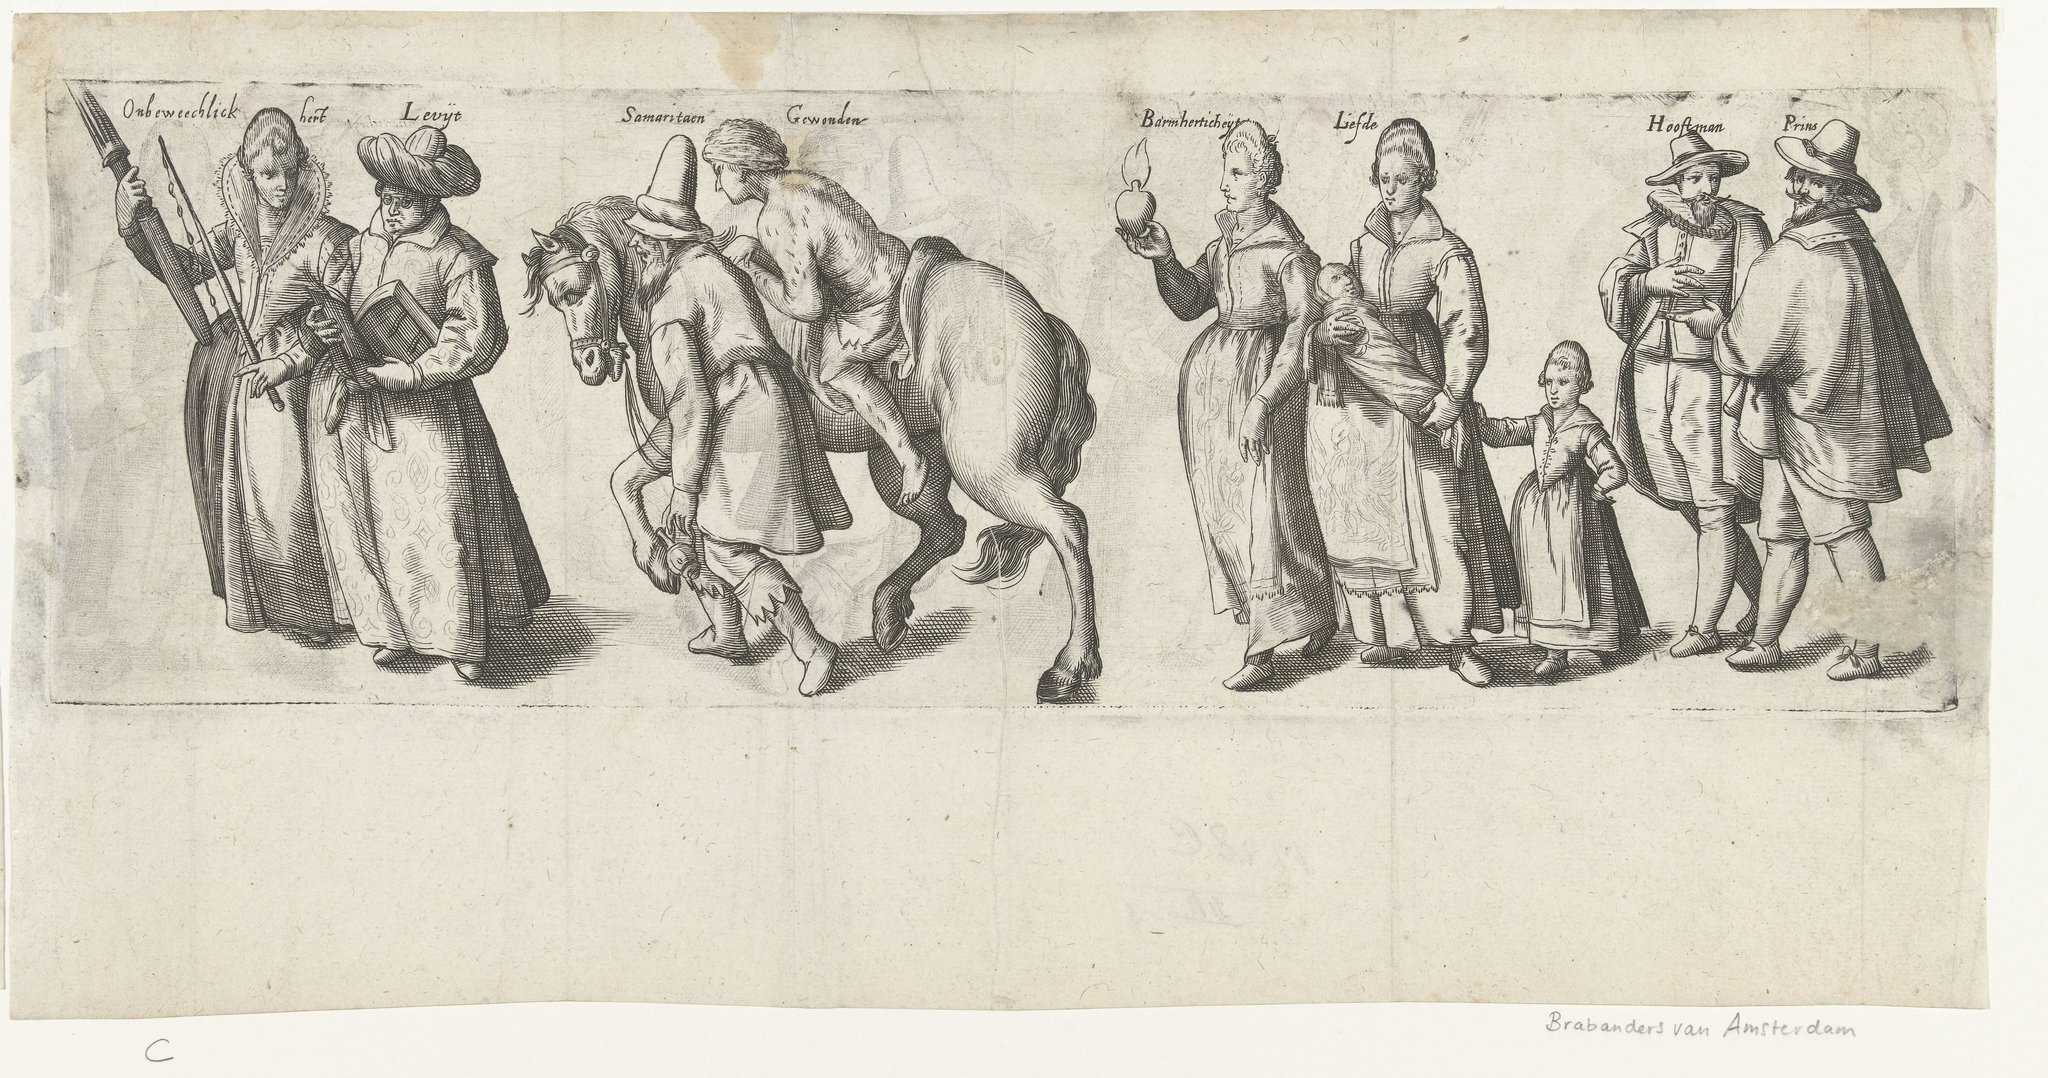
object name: print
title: De intrede van de Brabanders van Amsterdam verthoont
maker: Anonymous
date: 1607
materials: paper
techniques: engraving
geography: northern netherlands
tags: the good samaritan (luke 10:30-37), chamber of rhetoric (dutch: 'rederijkerskamer'), festivities (+ parade, pageant, cavalcade ~ festive activities), haarlem, amsterdam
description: Gebruikt als illustratie in: Const-thoonende ivweel, by de loflijcke stadt Haerlem, ten versoecke van Trou moet blijcken, in't licht gebracht. : Waer inne duydelick verclaert ende verthoont wordt alles wat den mensche mach wecken om den armen te troosten, ende zijnen naesten by te staen. : In twaelf spelen van sinne ... in redenrijck naar de volgende voorgegevene caerte van 't speel-korenken, Zacharias Heyns, Zwolle 1607. Los fragment, bedoeld om samen met de andere delen tot een fries gemonteerd te worden.